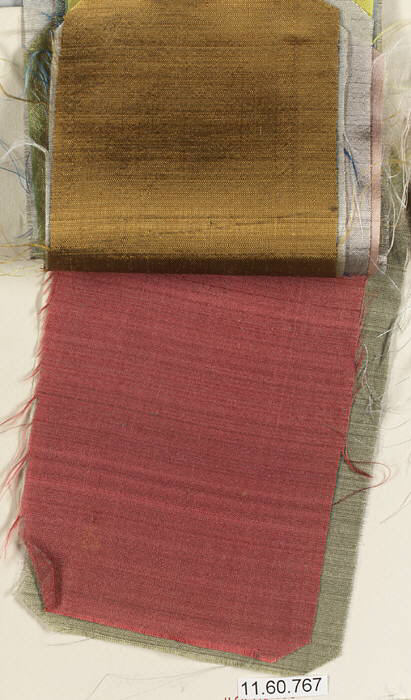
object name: sample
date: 1801-1833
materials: silk